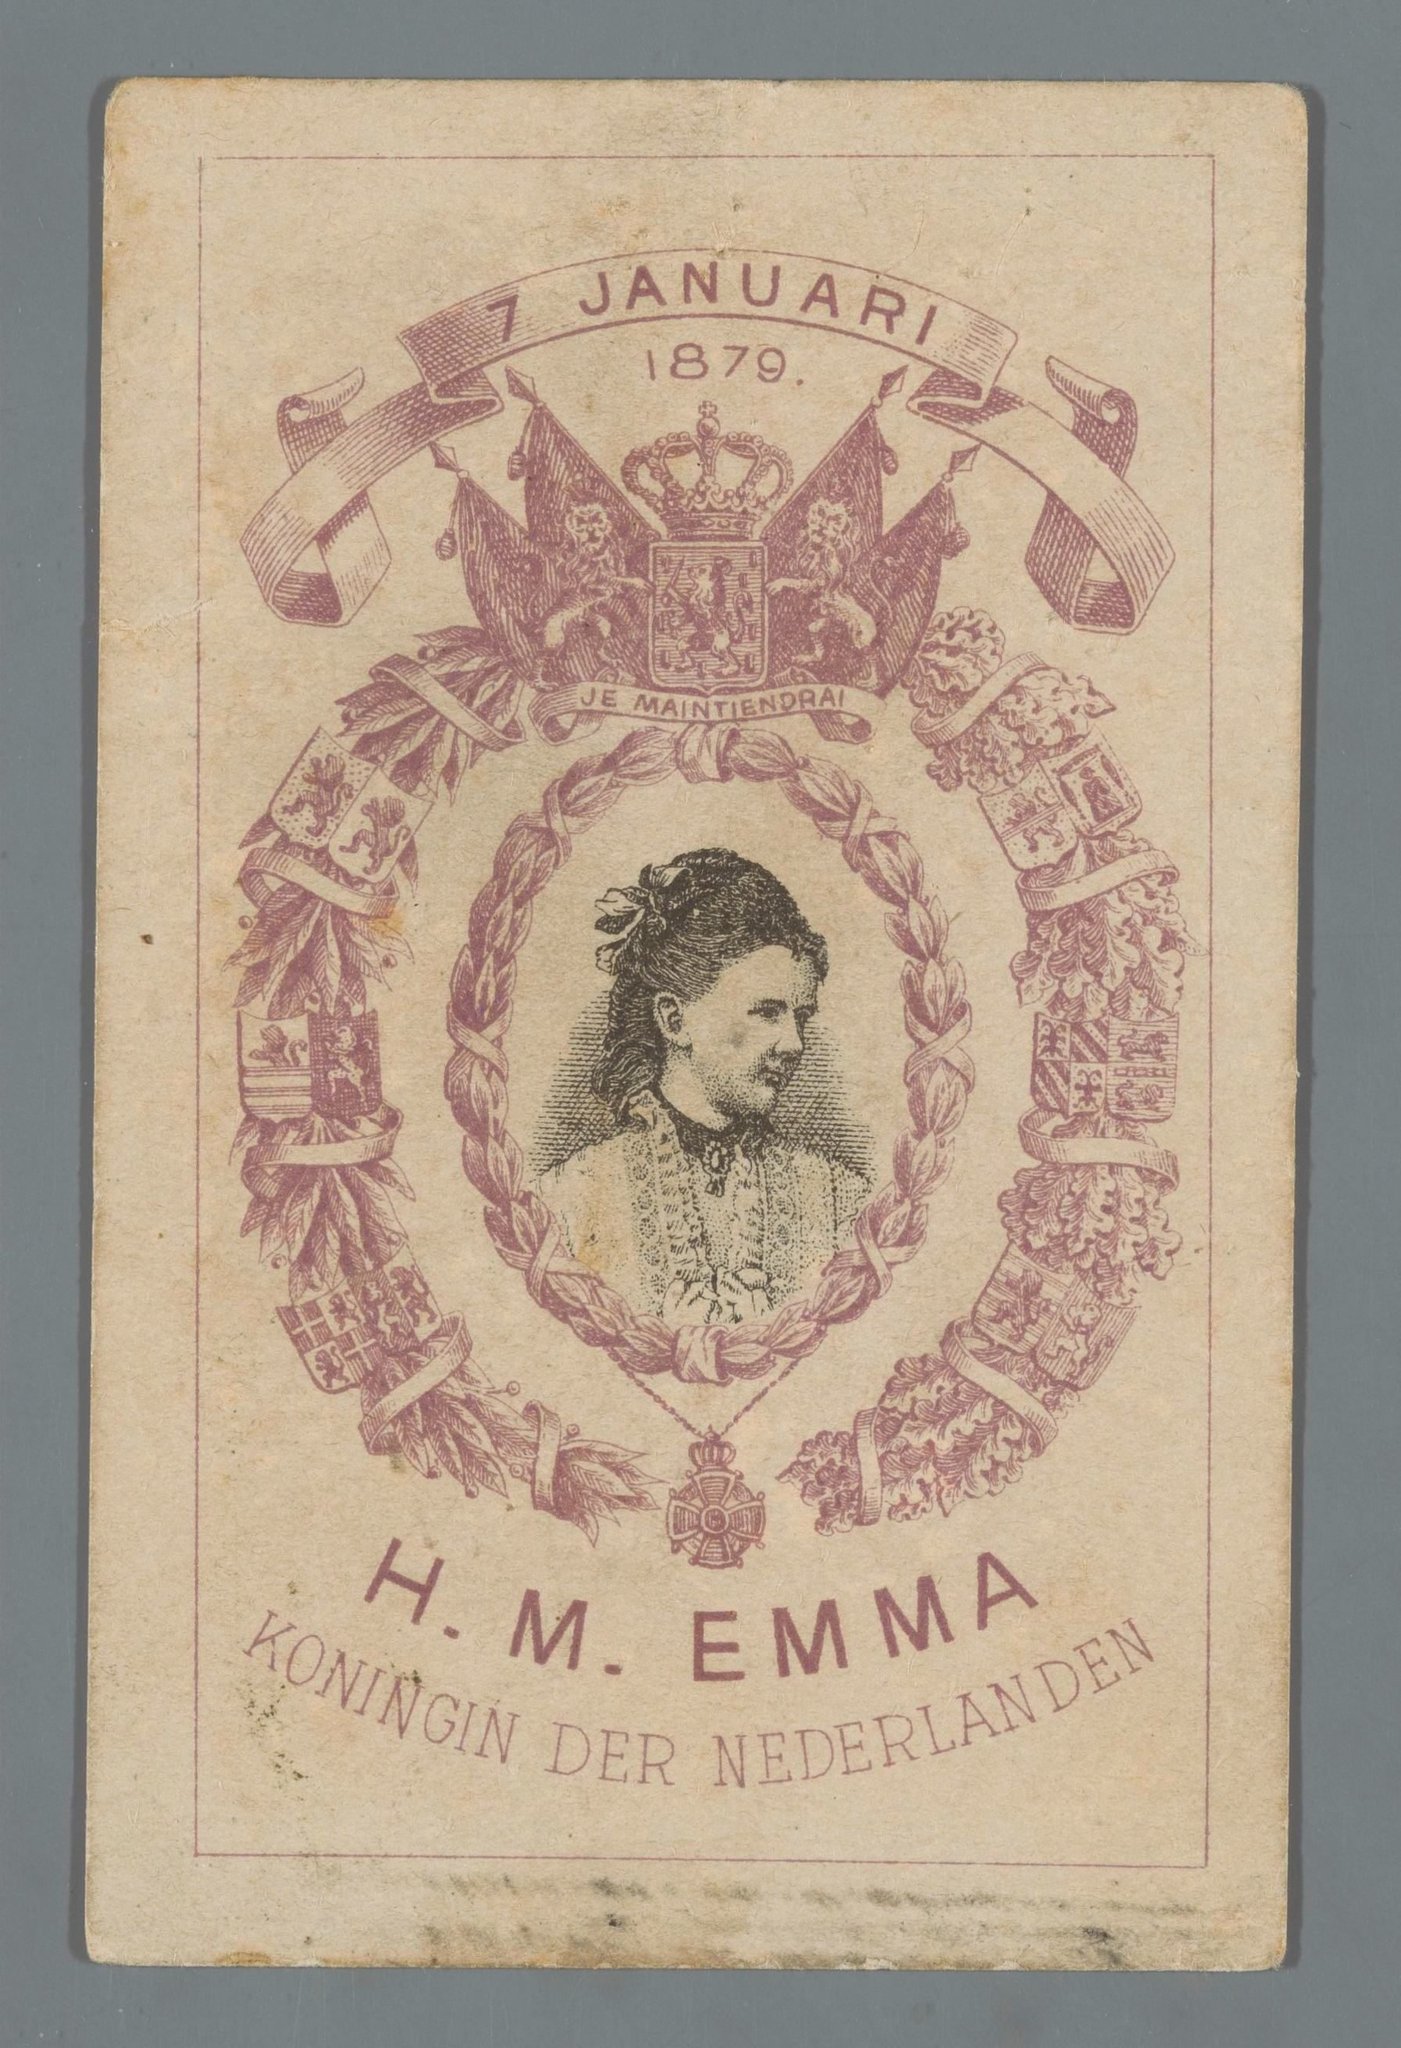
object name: carte de visite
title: Portret van Emma van Waldeck-Pyrmont bij gelegenheid van haar huwelijk met koning Willem III in 1879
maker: Anonymous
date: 1879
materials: paper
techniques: lithograph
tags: the hague, emma (queen consort of the netherlands), brussels, willem iii (koning der nederlanden), historical persons - bb - woman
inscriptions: annotation: ‘7 JANUARI // 1879 // H. M. EMMA // KONINGIN DER NEDERLANDEN’